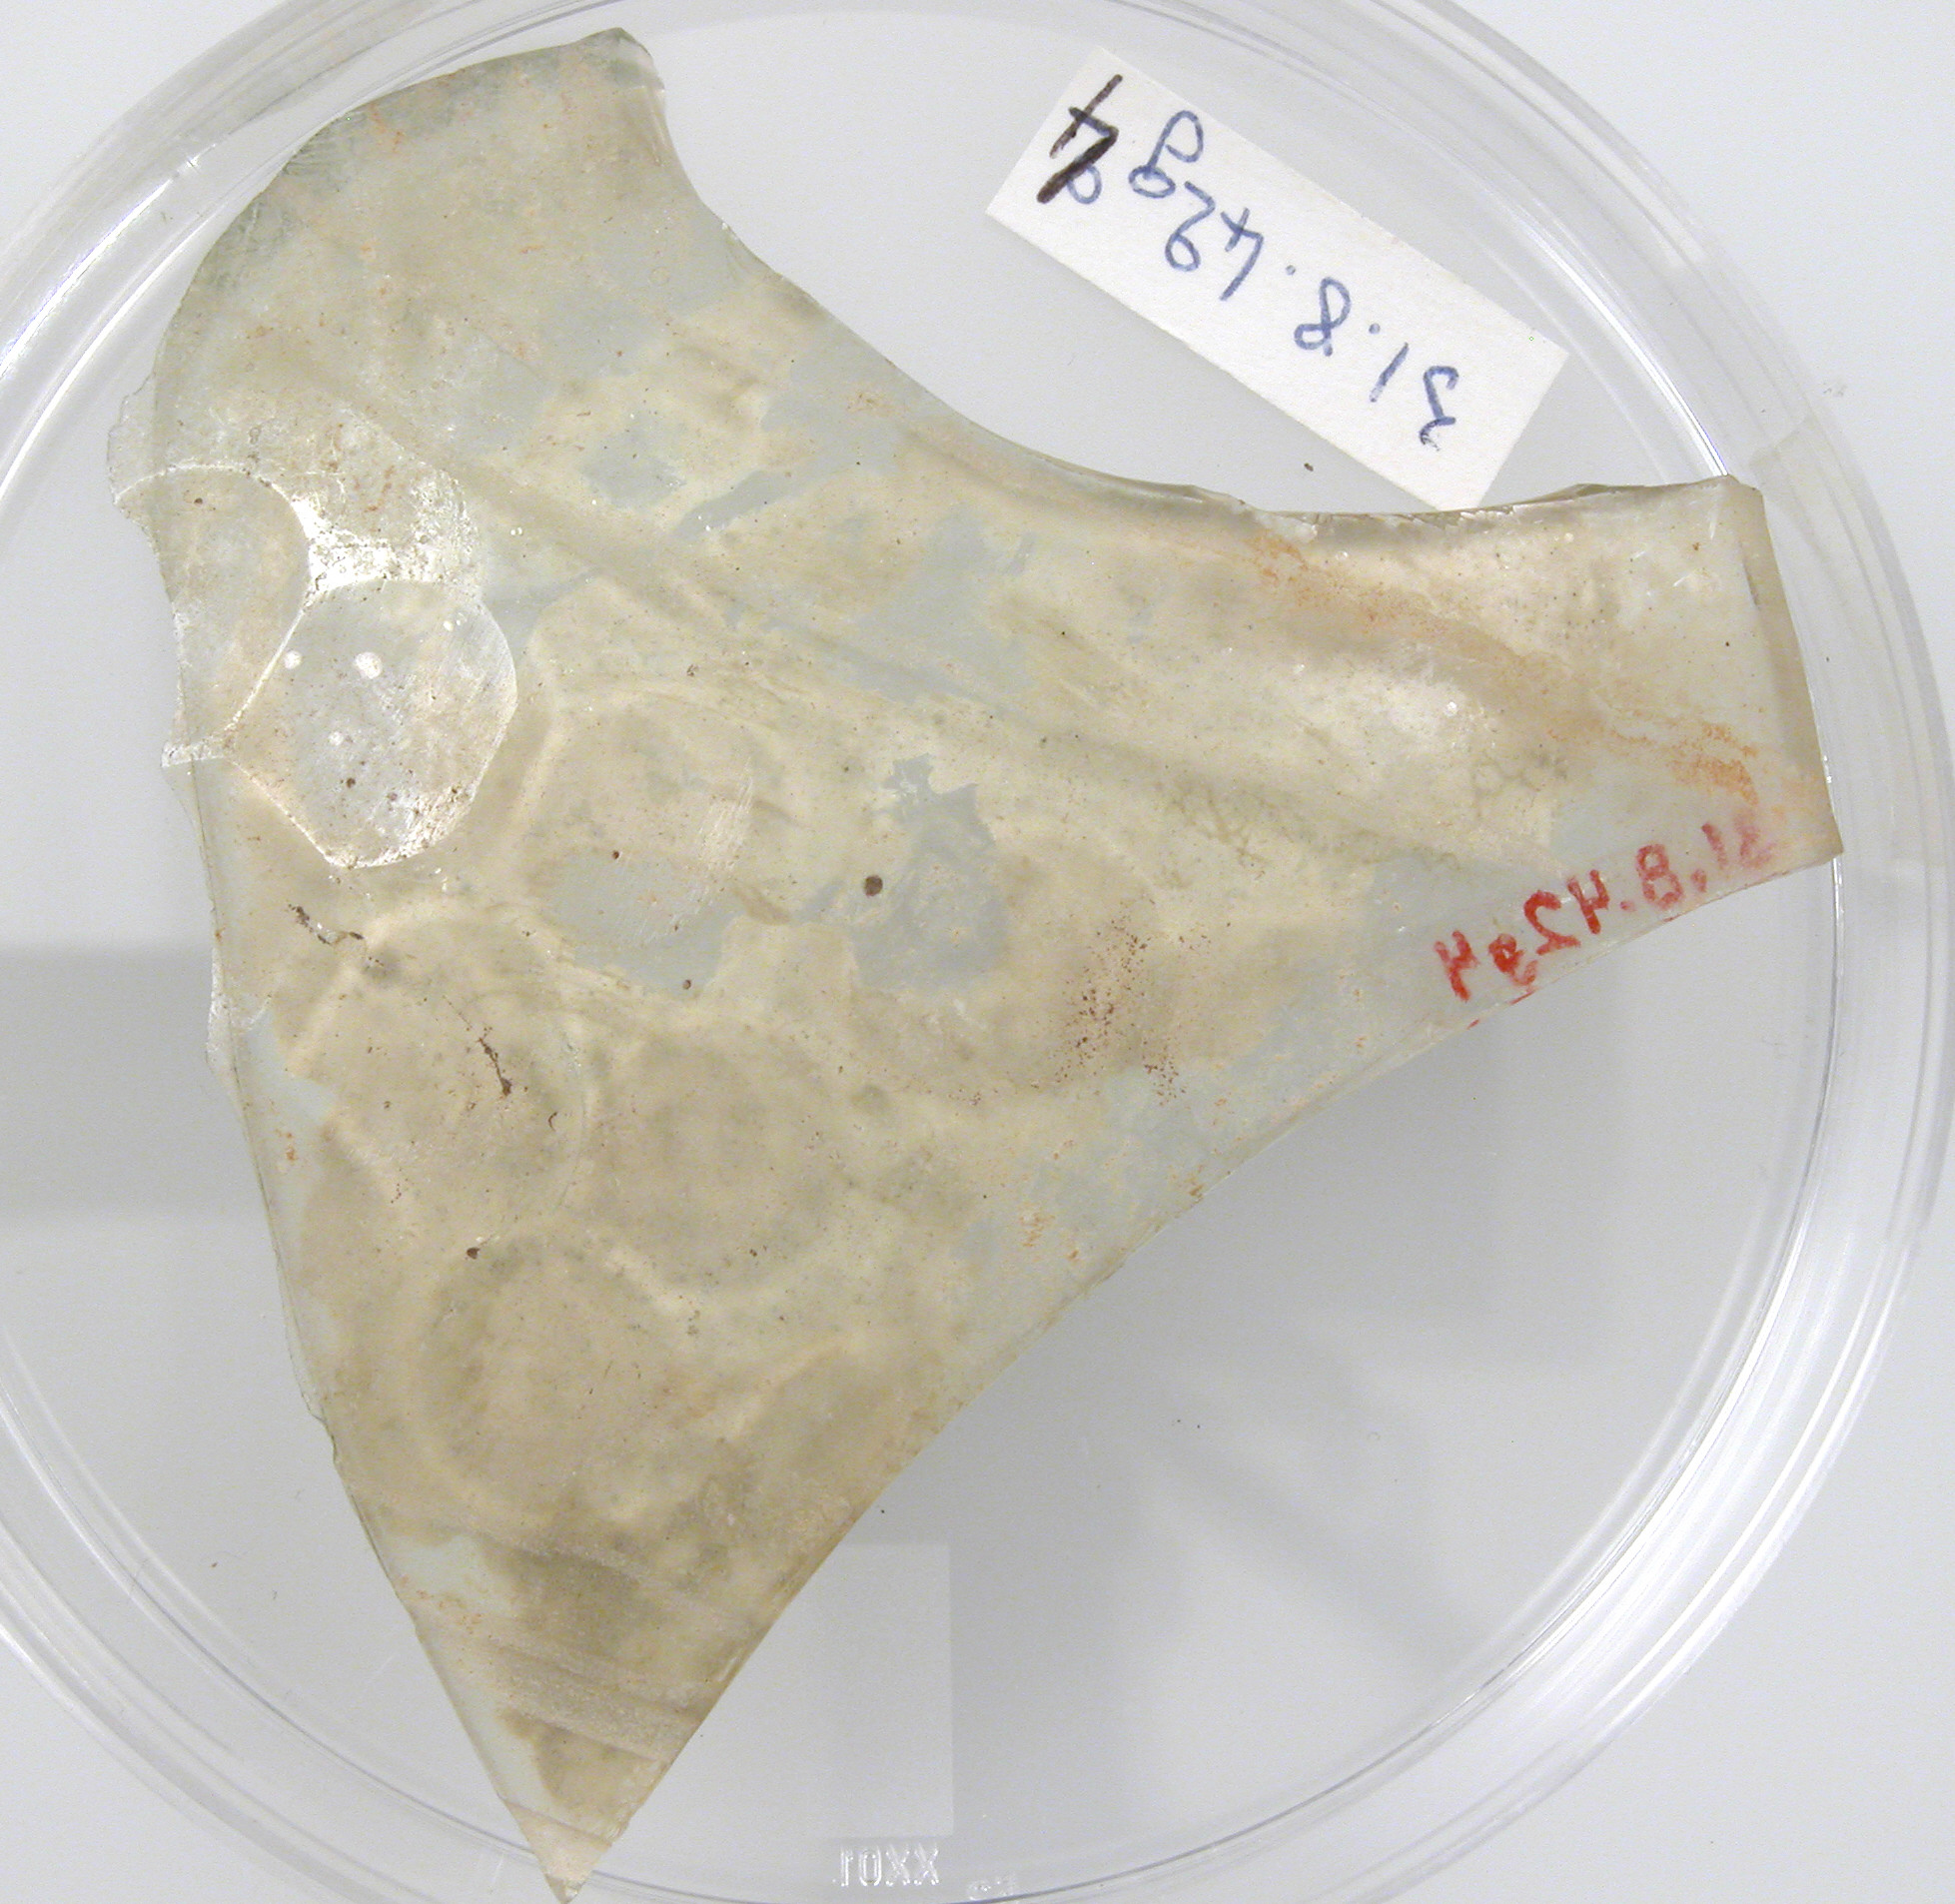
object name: fragment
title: Glass Fragment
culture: coptic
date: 301-400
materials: glass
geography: egypt